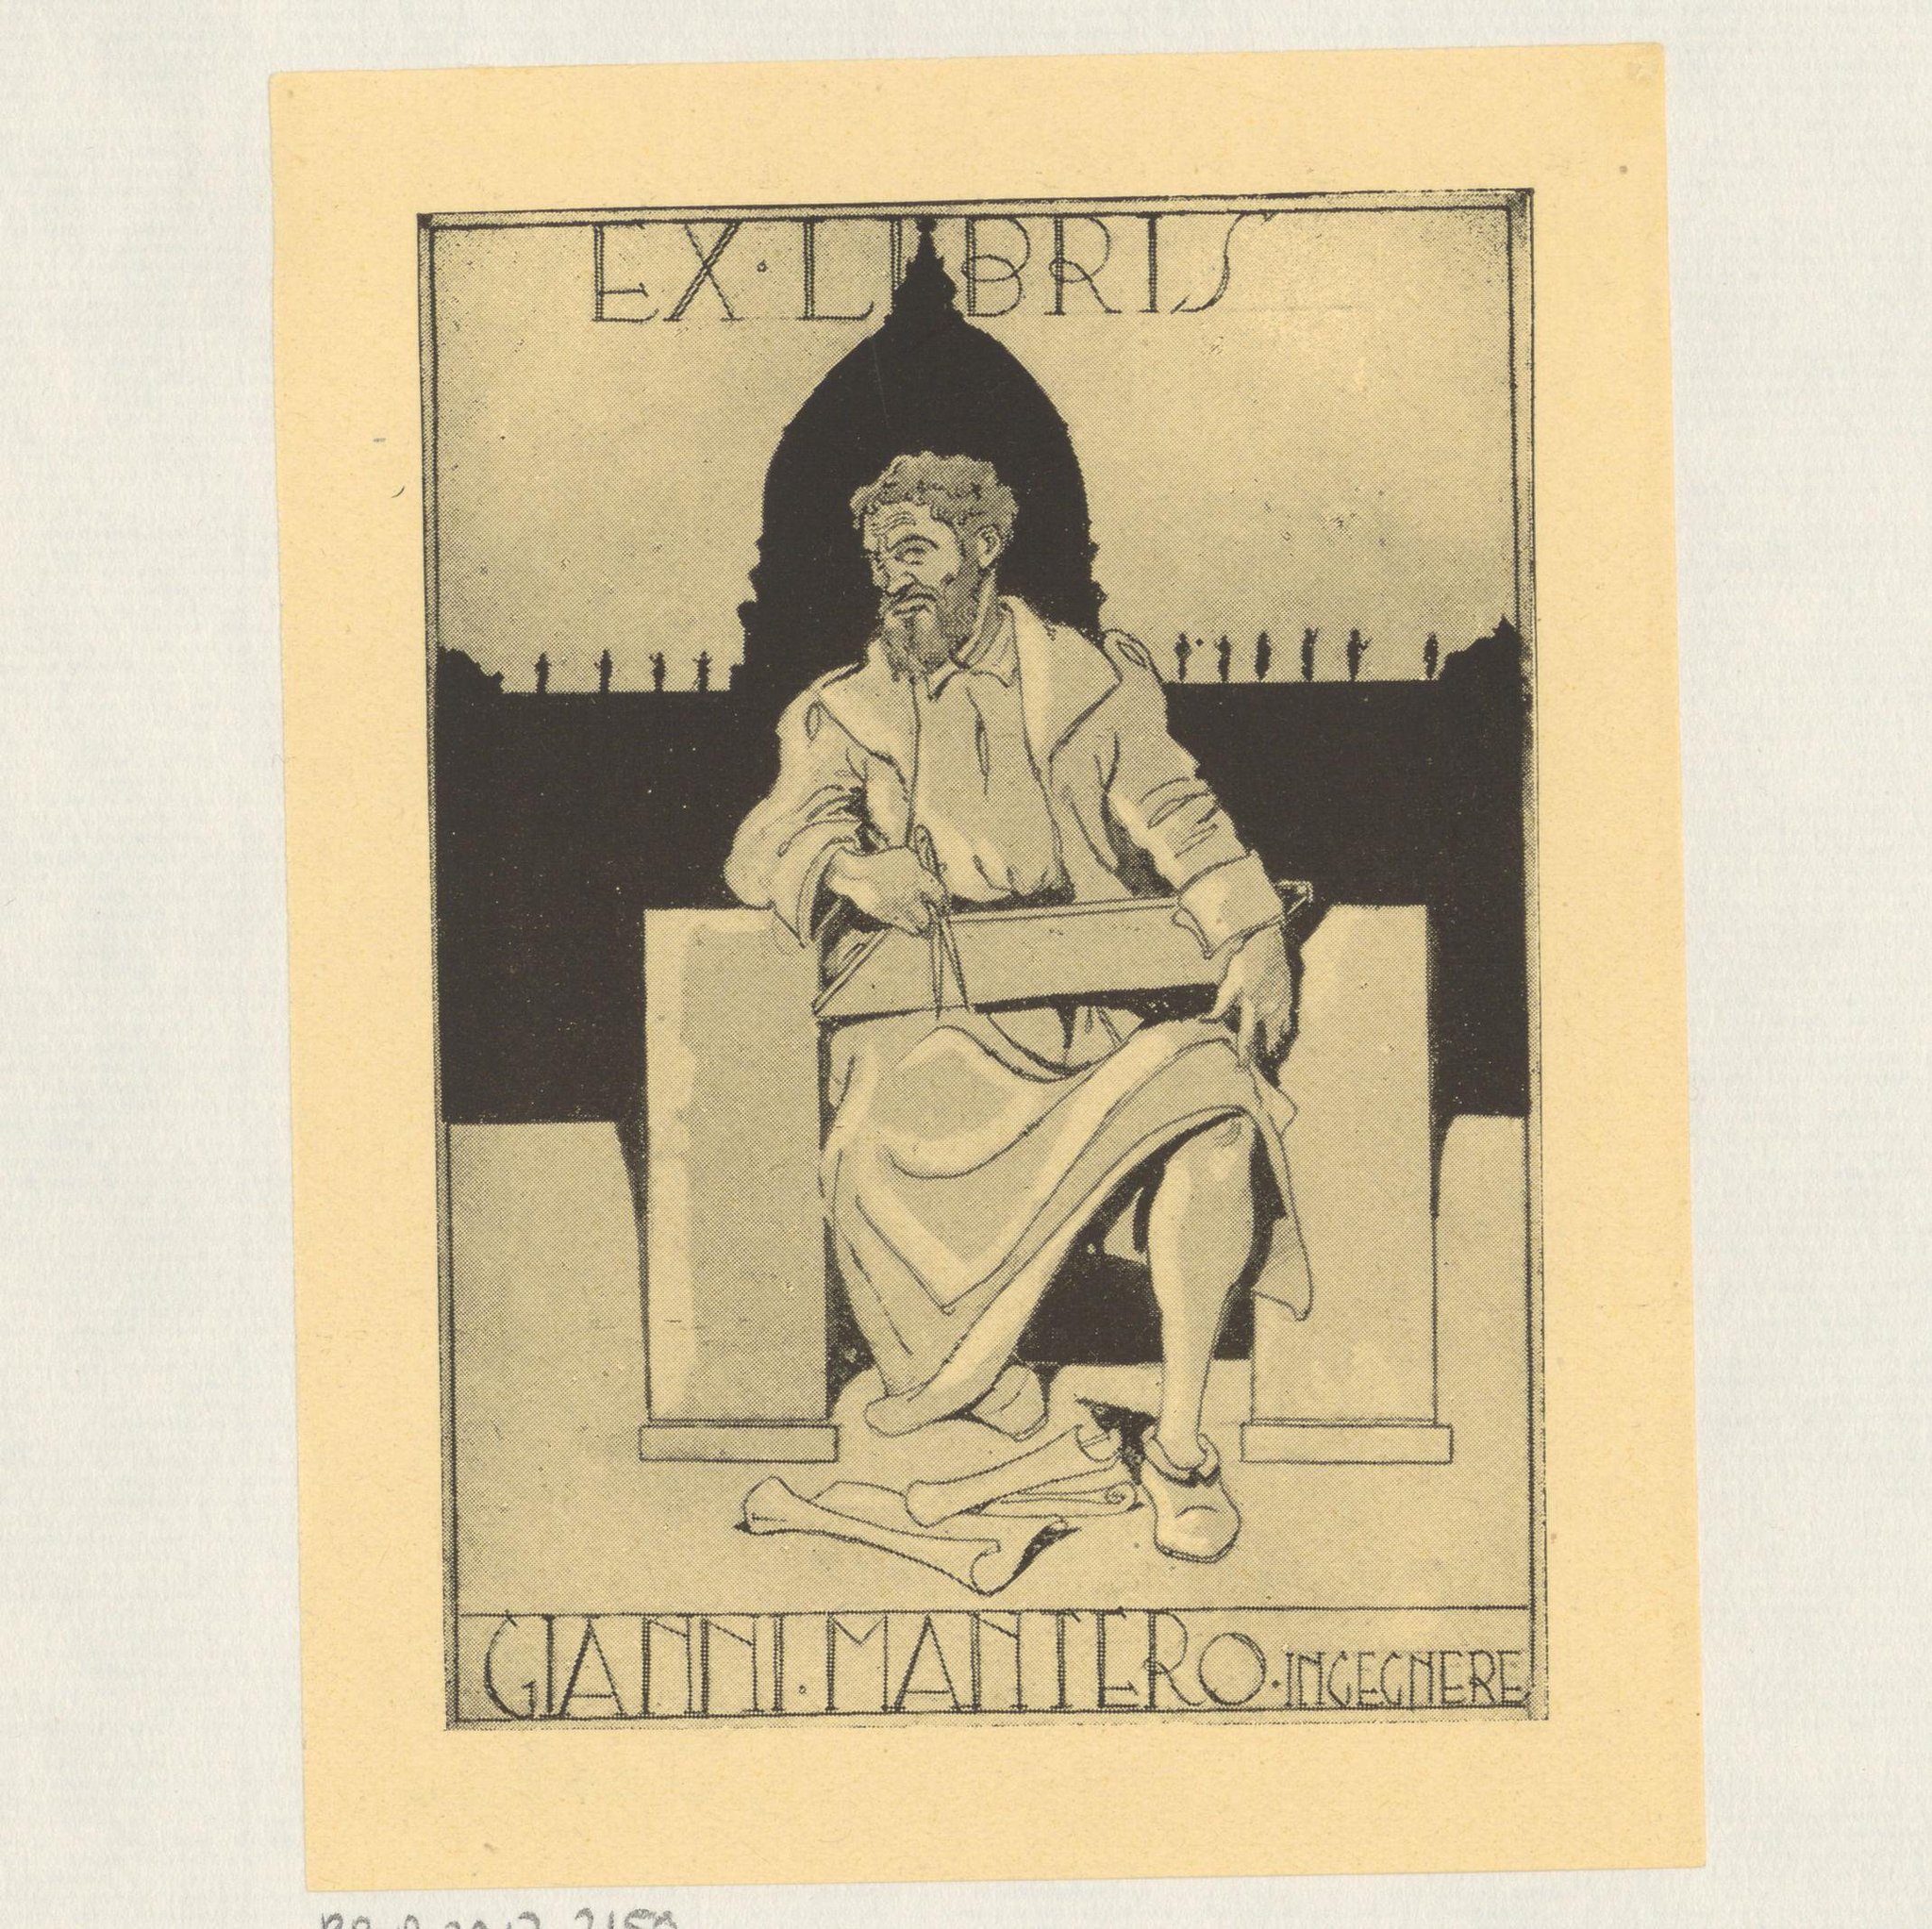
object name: photomechanical print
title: Ex libris van Gianni Mantero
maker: Anonymous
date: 1910-1954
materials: paper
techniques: autotype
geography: italy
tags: engineer, gianni mantero, rome, painter, draughtsman, sculptor, michelangelo, portrait, self-portrait of architect, church (exterior)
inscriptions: inscription: ‘383 / Burzi’